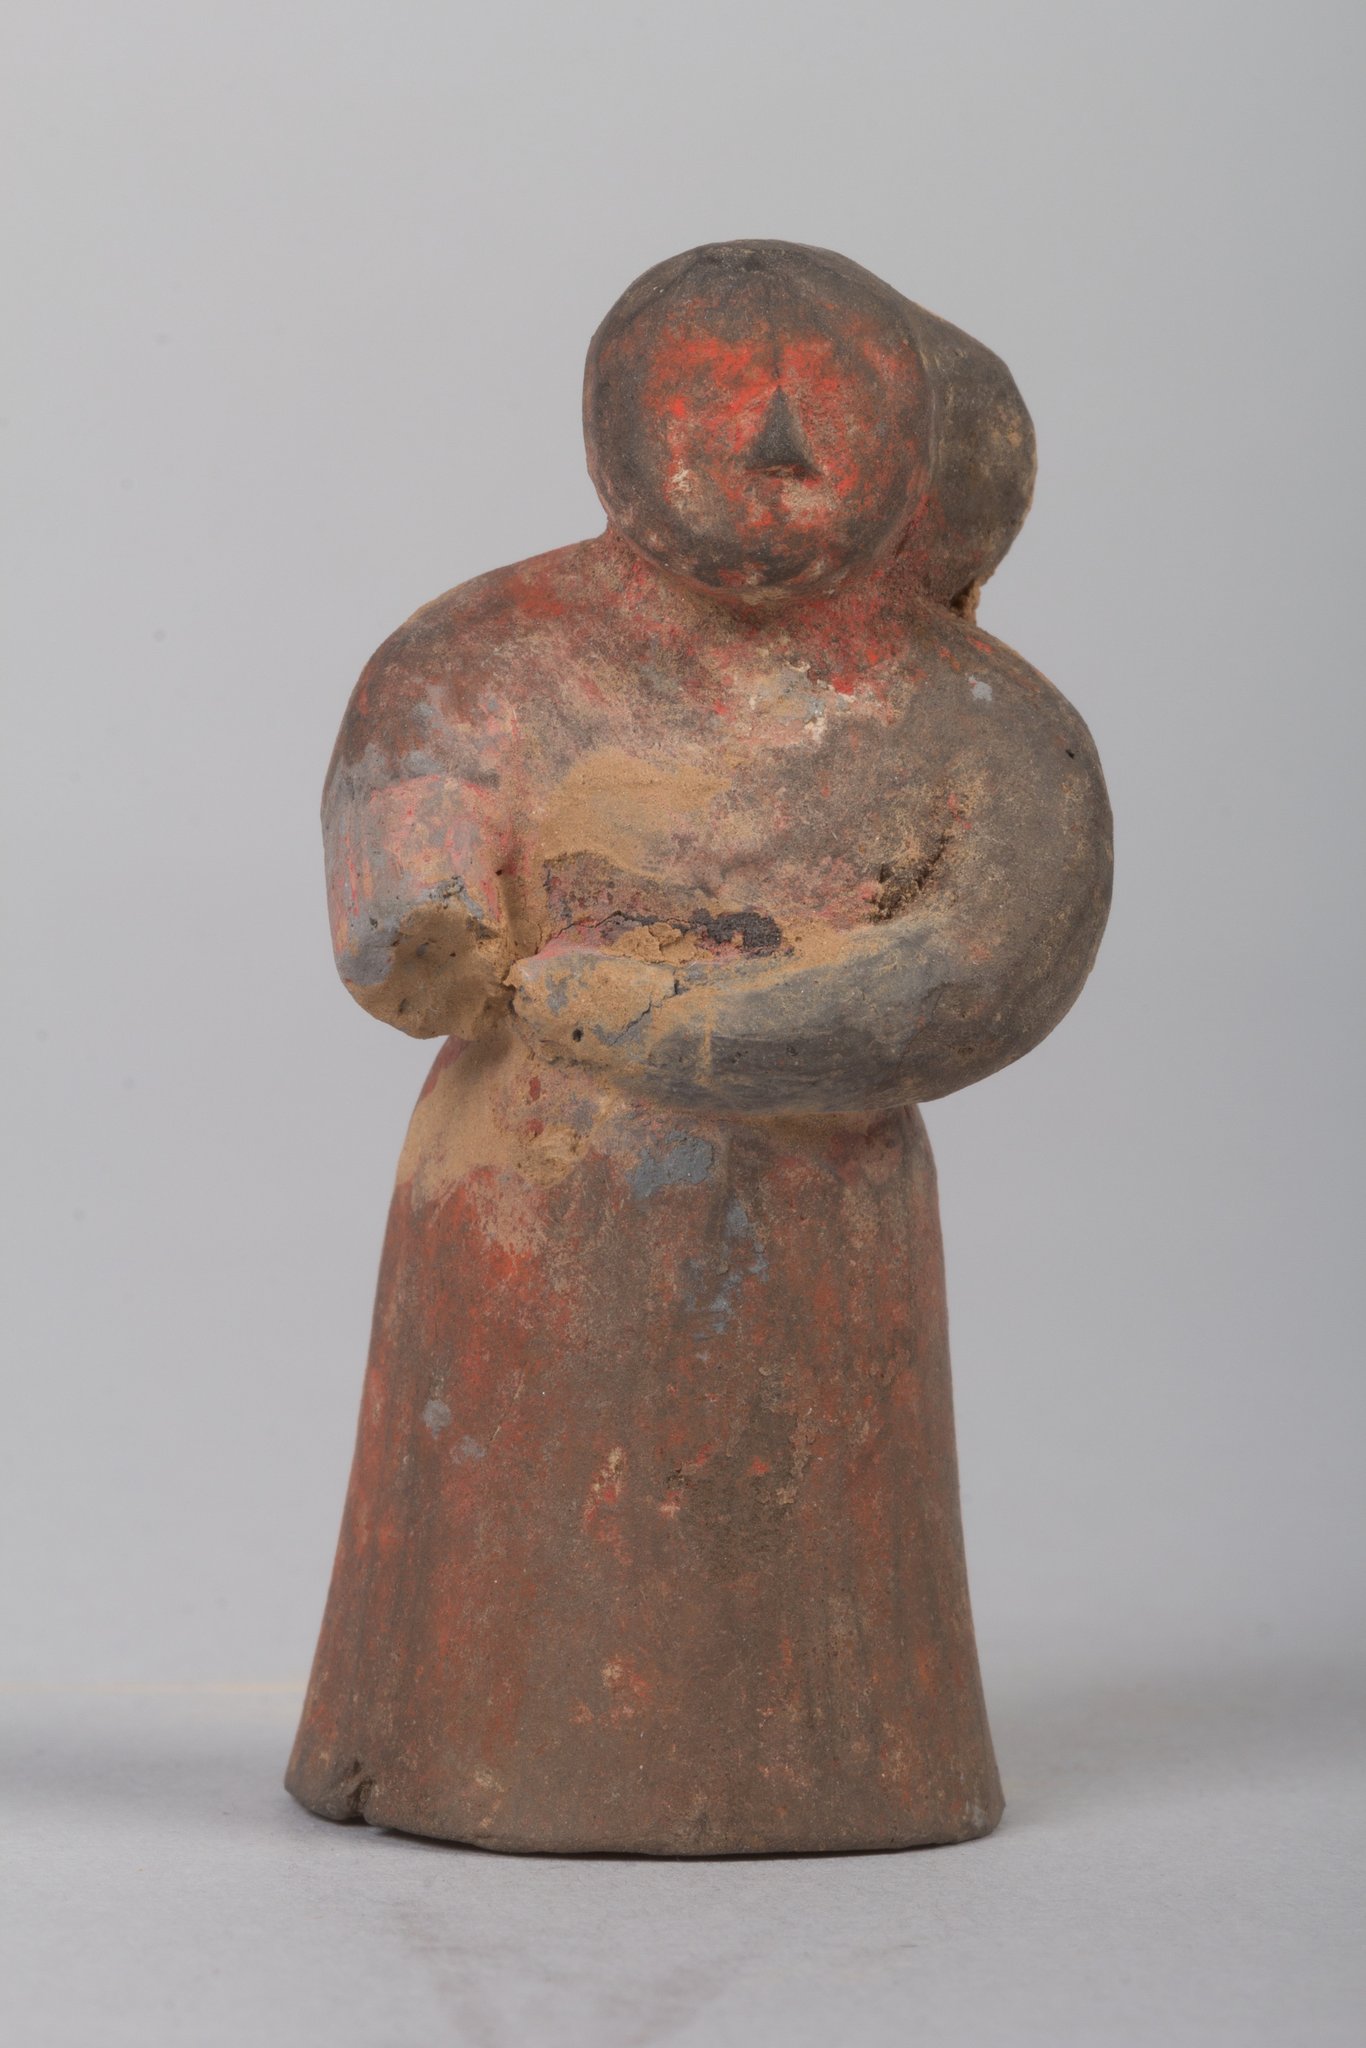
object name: figure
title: Figure of a woman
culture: chinese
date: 400-201 BCE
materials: clay